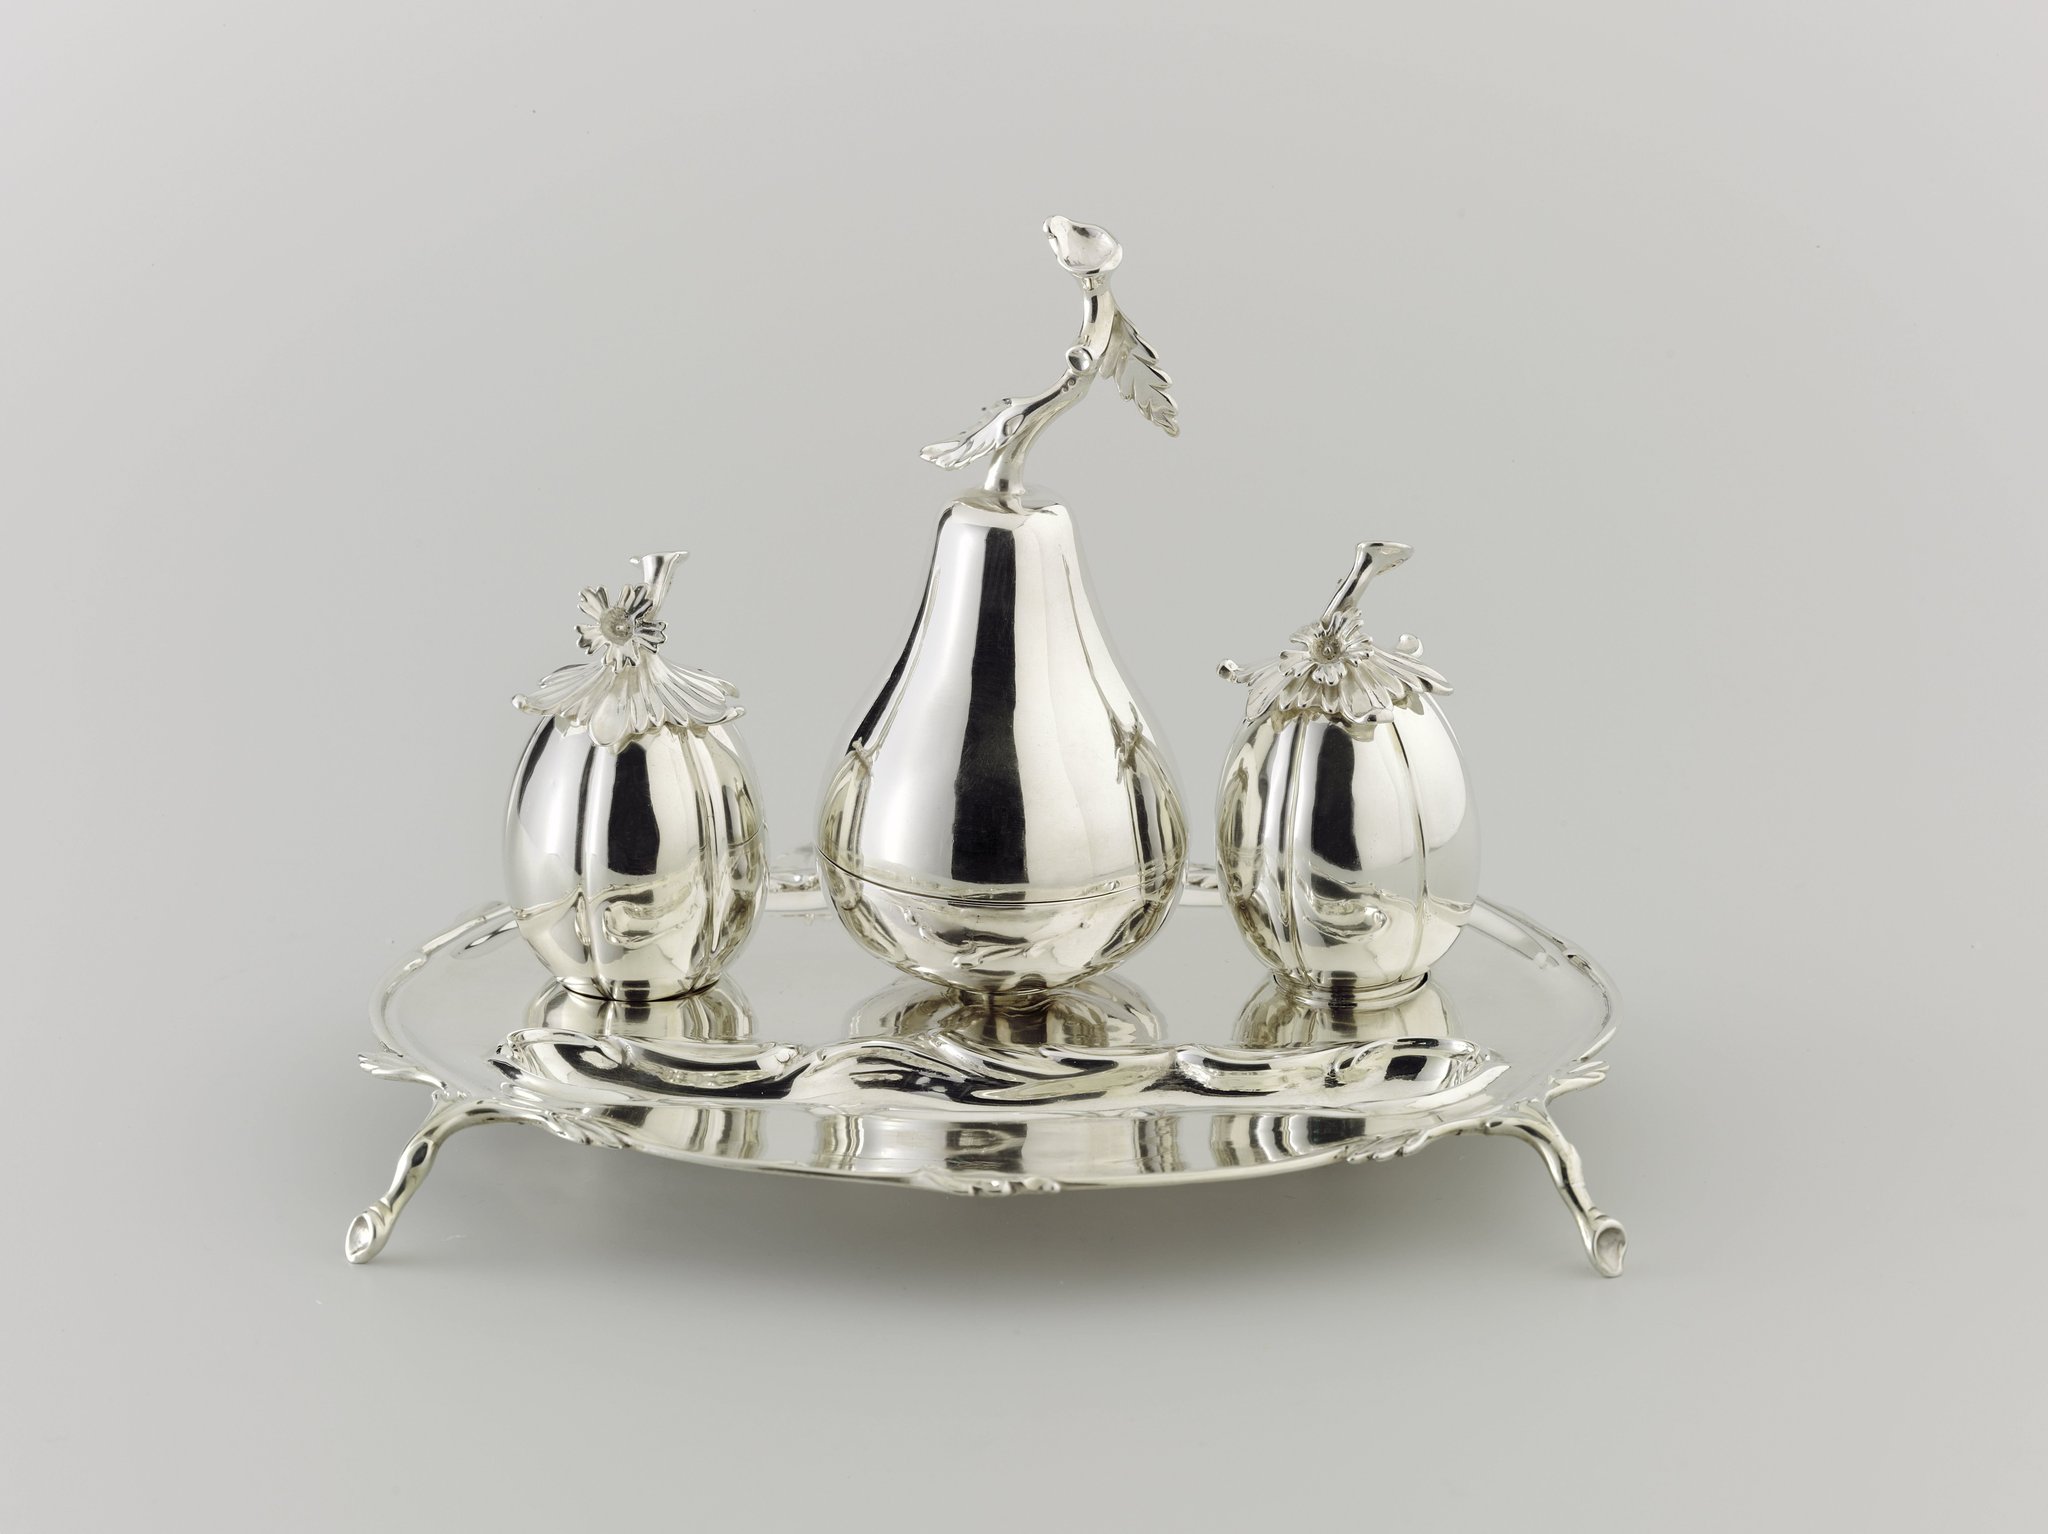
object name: inkstand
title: Bel behorend bij inktstel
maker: laurens potmans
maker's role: goud- en zilversmid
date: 1773-1782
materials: silver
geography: middelburg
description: Inktstel van zilver. Het blad is aan de achterzijde recht en aan de voorzijde gebogen. De inktpot en zandstrooier zijn meloenvormig. Tussen de twee meloenen is de peervormige tafelbel aangebracht.